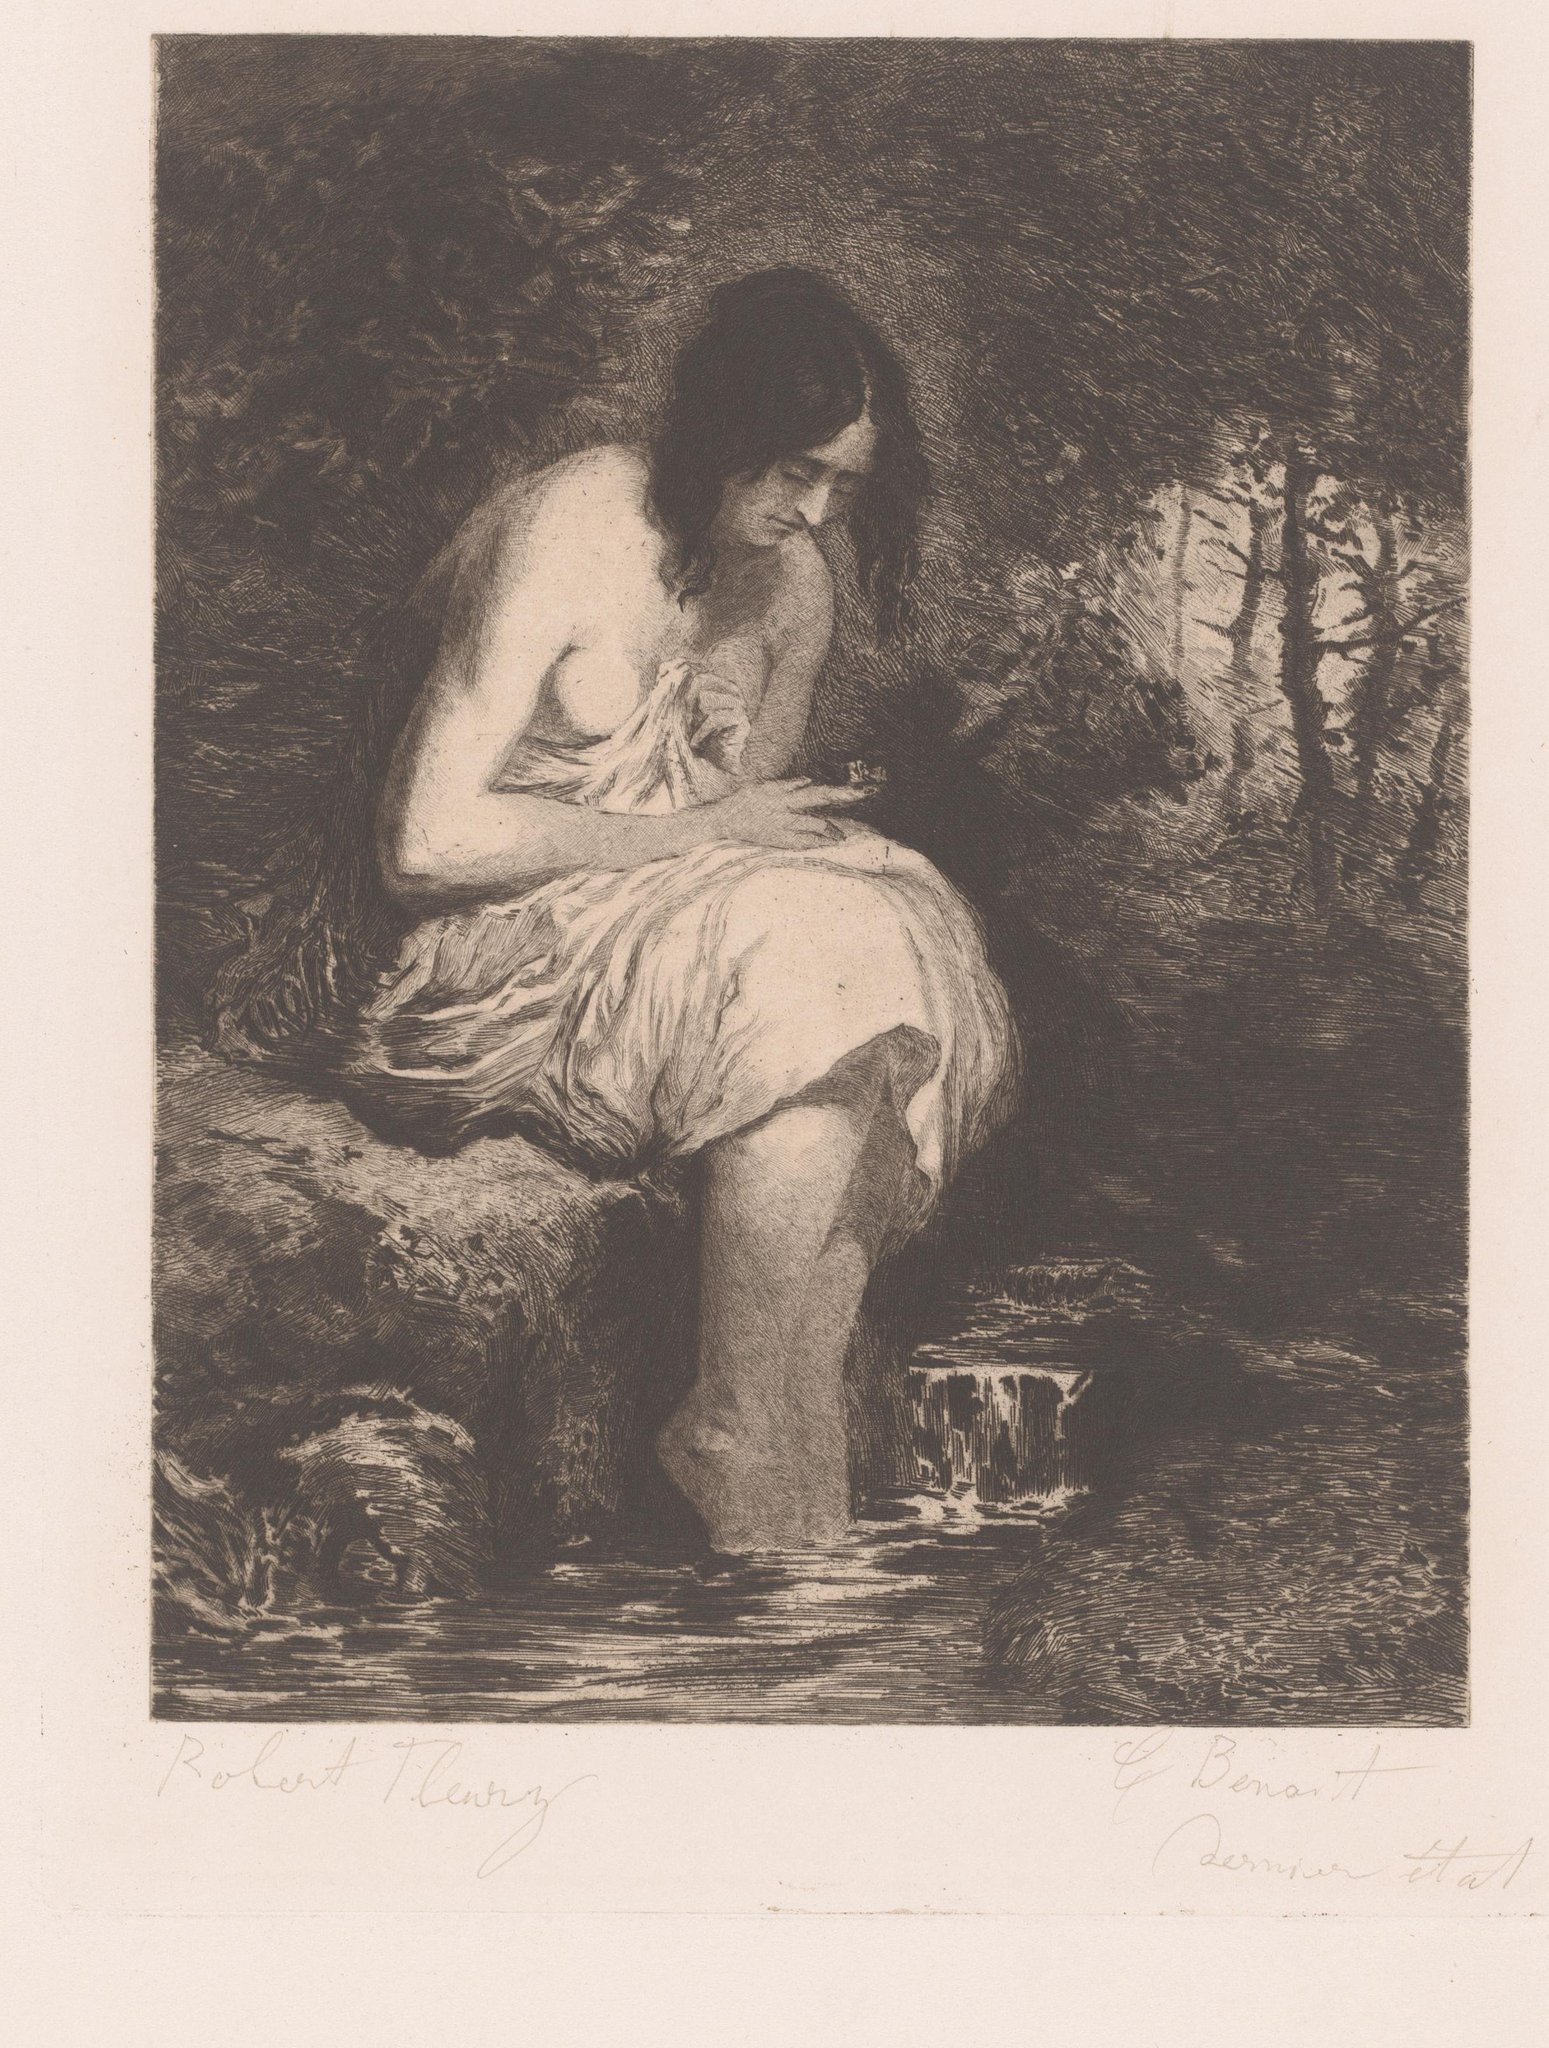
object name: print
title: Badende jonge vrouw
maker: clément benoit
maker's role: draughtsman, painter, print maker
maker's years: 1866-1953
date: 1890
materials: paper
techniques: drypoint, etching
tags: adolescent, young woman, maiden, washing and bathing - aa - in the open air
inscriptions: collector's mark: Lugt 2228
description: Naast de signatuur en staat-vermelding van de prentmaker, wordt ook de naam Robert Fleury onder de afbeelding vermeld.